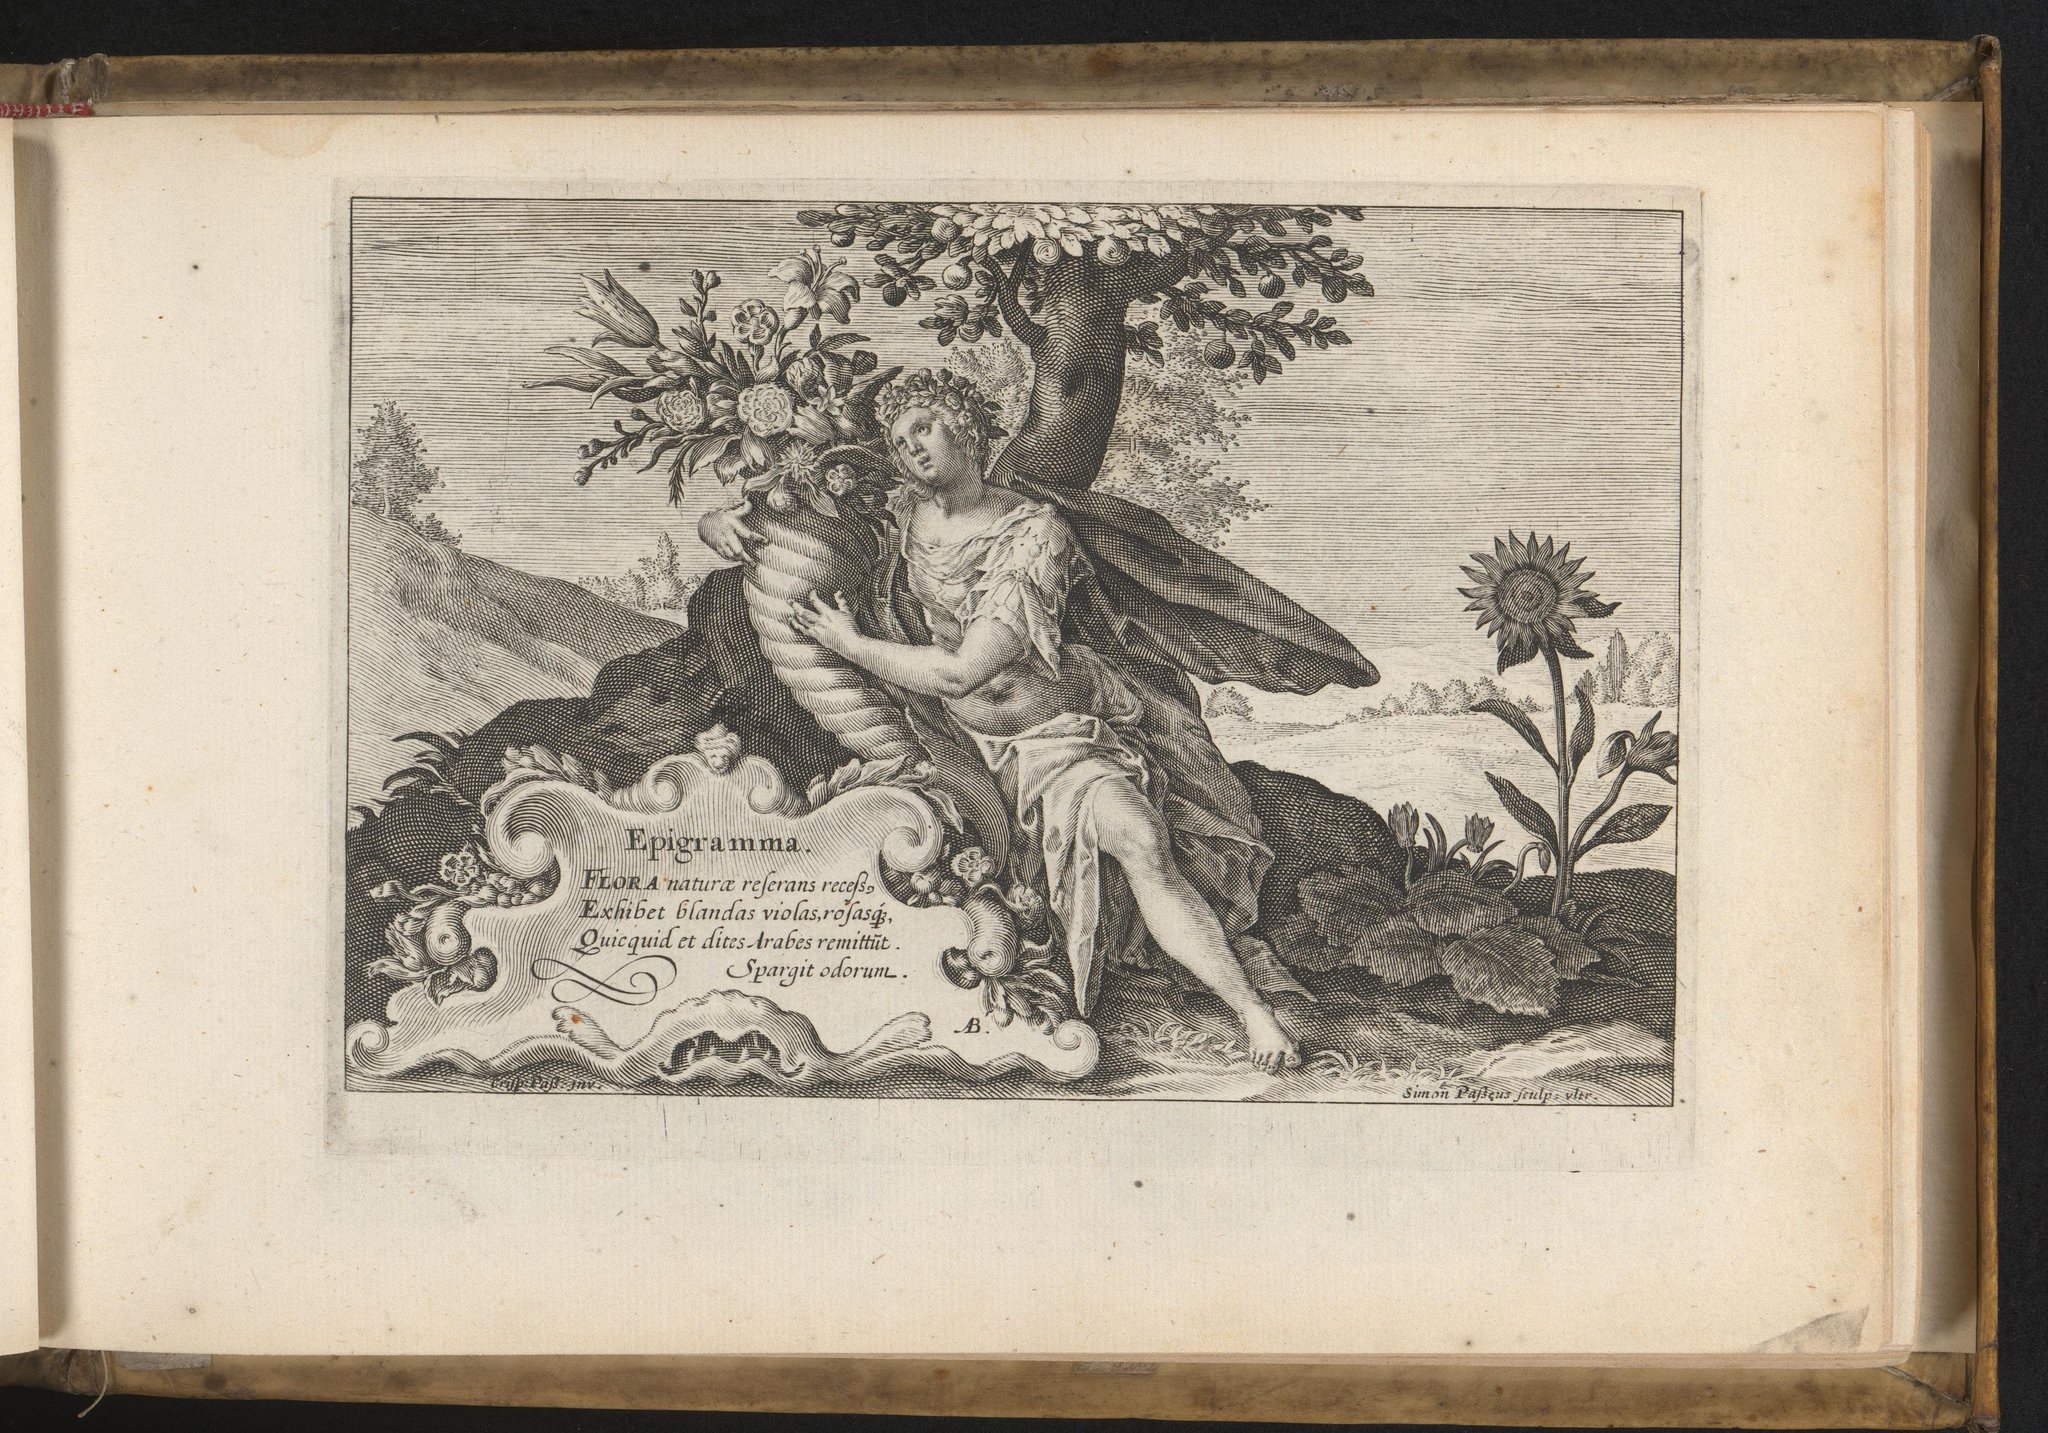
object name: page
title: Bloemtuin van de herfst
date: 1617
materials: paper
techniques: engraving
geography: utrecht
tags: 'cornucopia', horn of plenty, (story of) flora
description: Prent uit: Passe, Crispijn van de (II). Hortus floridus in quo rariorum & minus vulgarium florum icones ad vivam veramque formam. Arnhem: Johannes Janssonius, 1617.